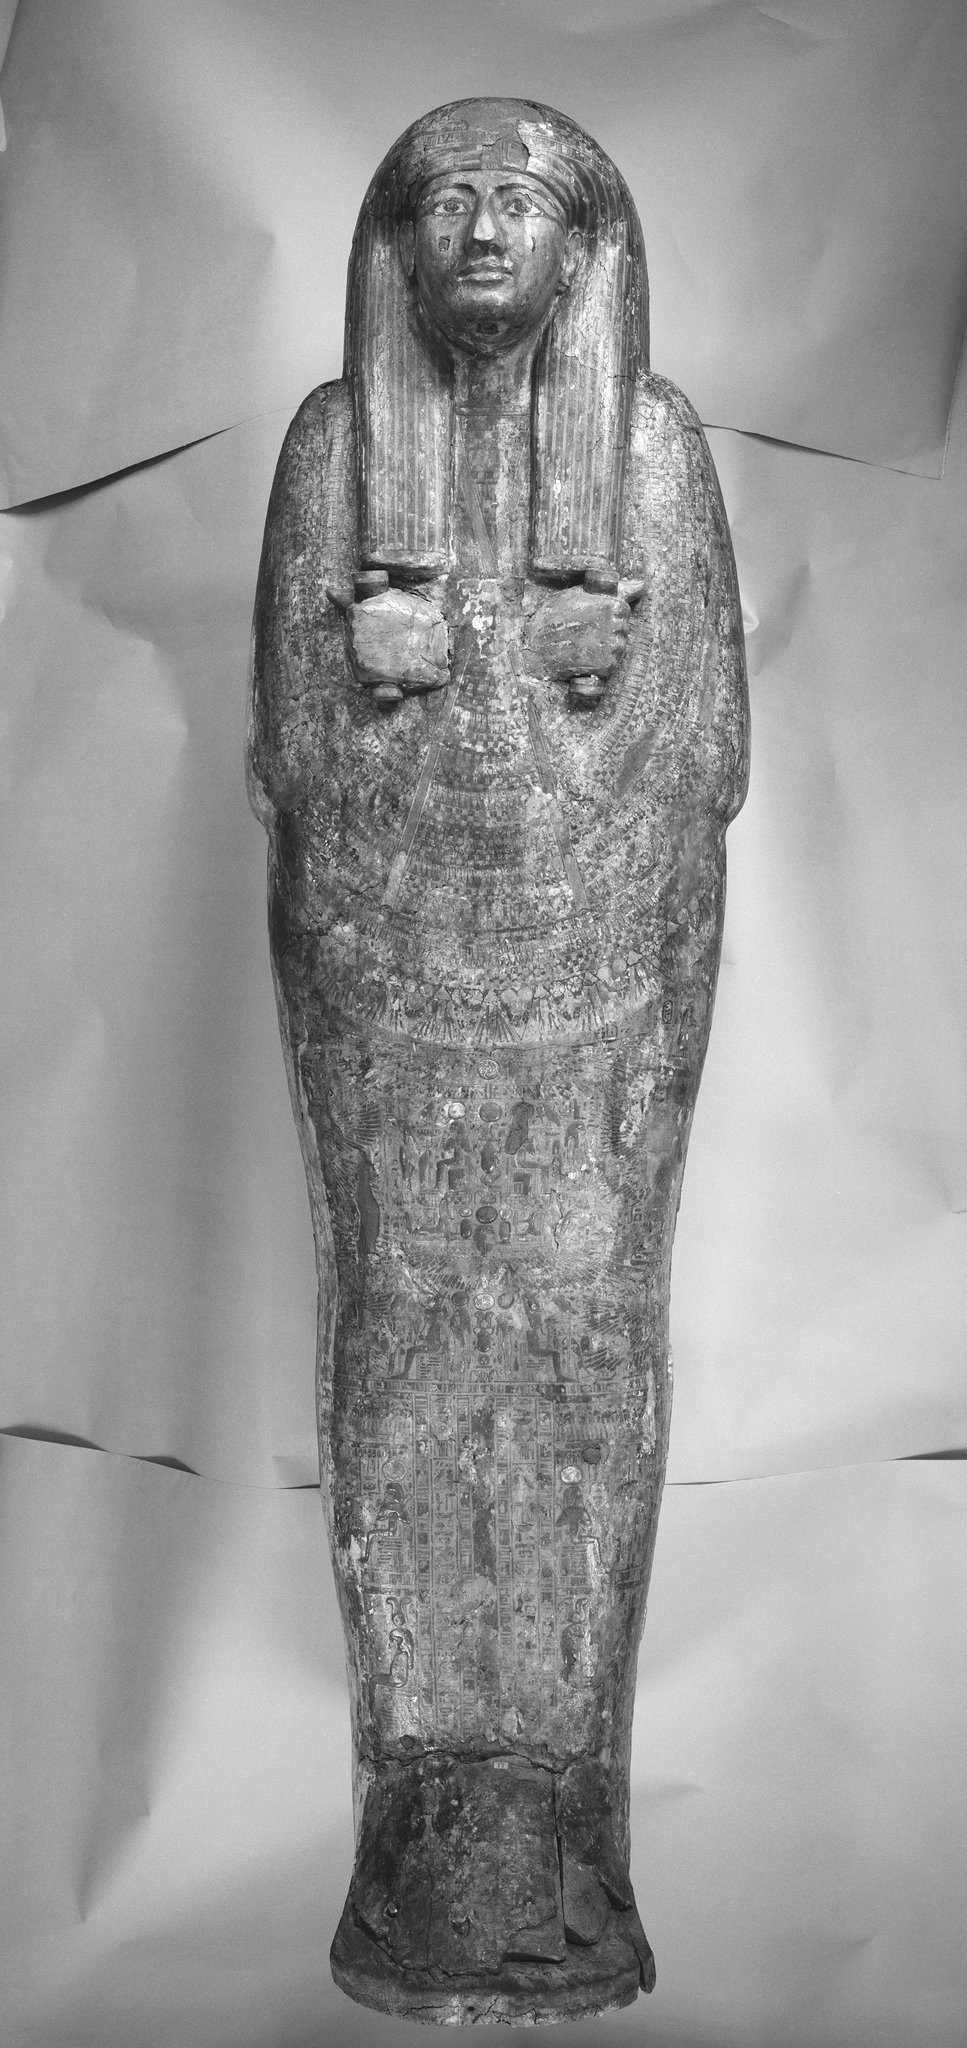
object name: coffin, unnamed priest or official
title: Anthropoid "Stola" Coffin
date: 975-900 BCE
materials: gesso, paint, varnish, wood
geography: egypt